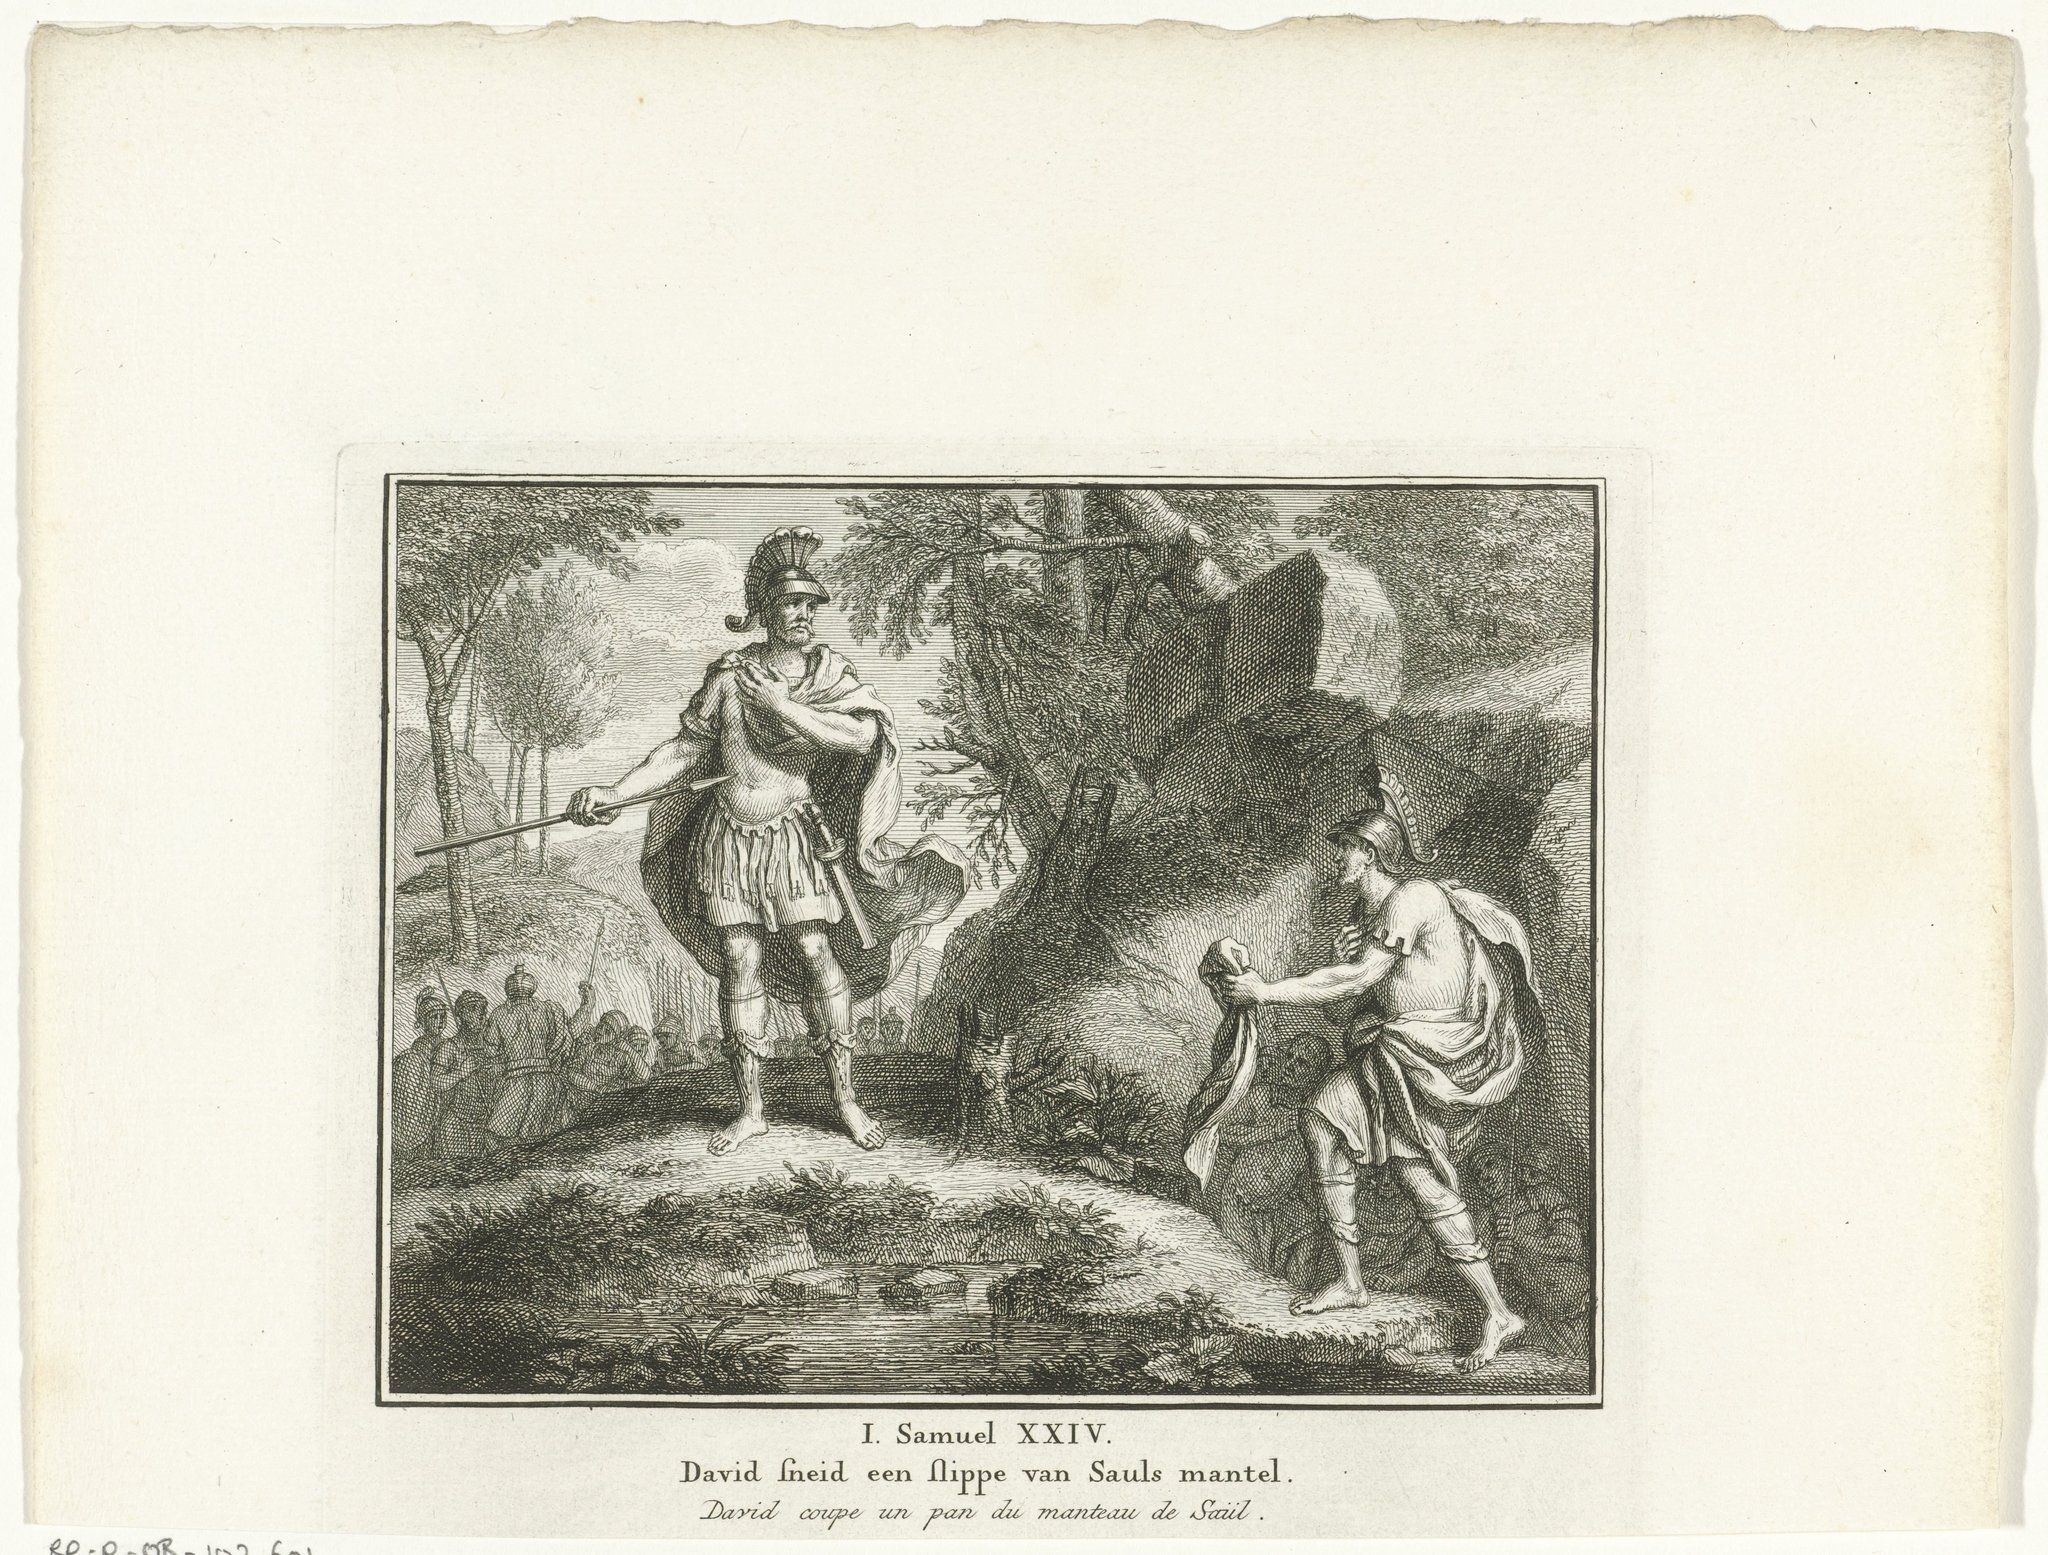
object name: print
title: David toont Saul het stuk van zijn mantel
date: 1791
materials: paper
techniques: etching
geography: dordrecht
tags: when saul comes out of the cave, david calls him, falls down on his knees and shows him the piece of cloth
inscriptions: collector's mark: Lugt 2228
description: Bijbelse voorstelling uit 1 Sam. 24. David weerhoudt zijn mannen ervan om Saul te doden. Hij toont de verraste Saul een stuk van diens mantel dat hij eerder afgesneden heeft. Onder de voorstelling staat de titel in het Nederlands en Frans. De titel omschrijft een gebeurtenis die eerder plaatsvond, namelijk het afsnijden van een stuk van Saul's mantel.